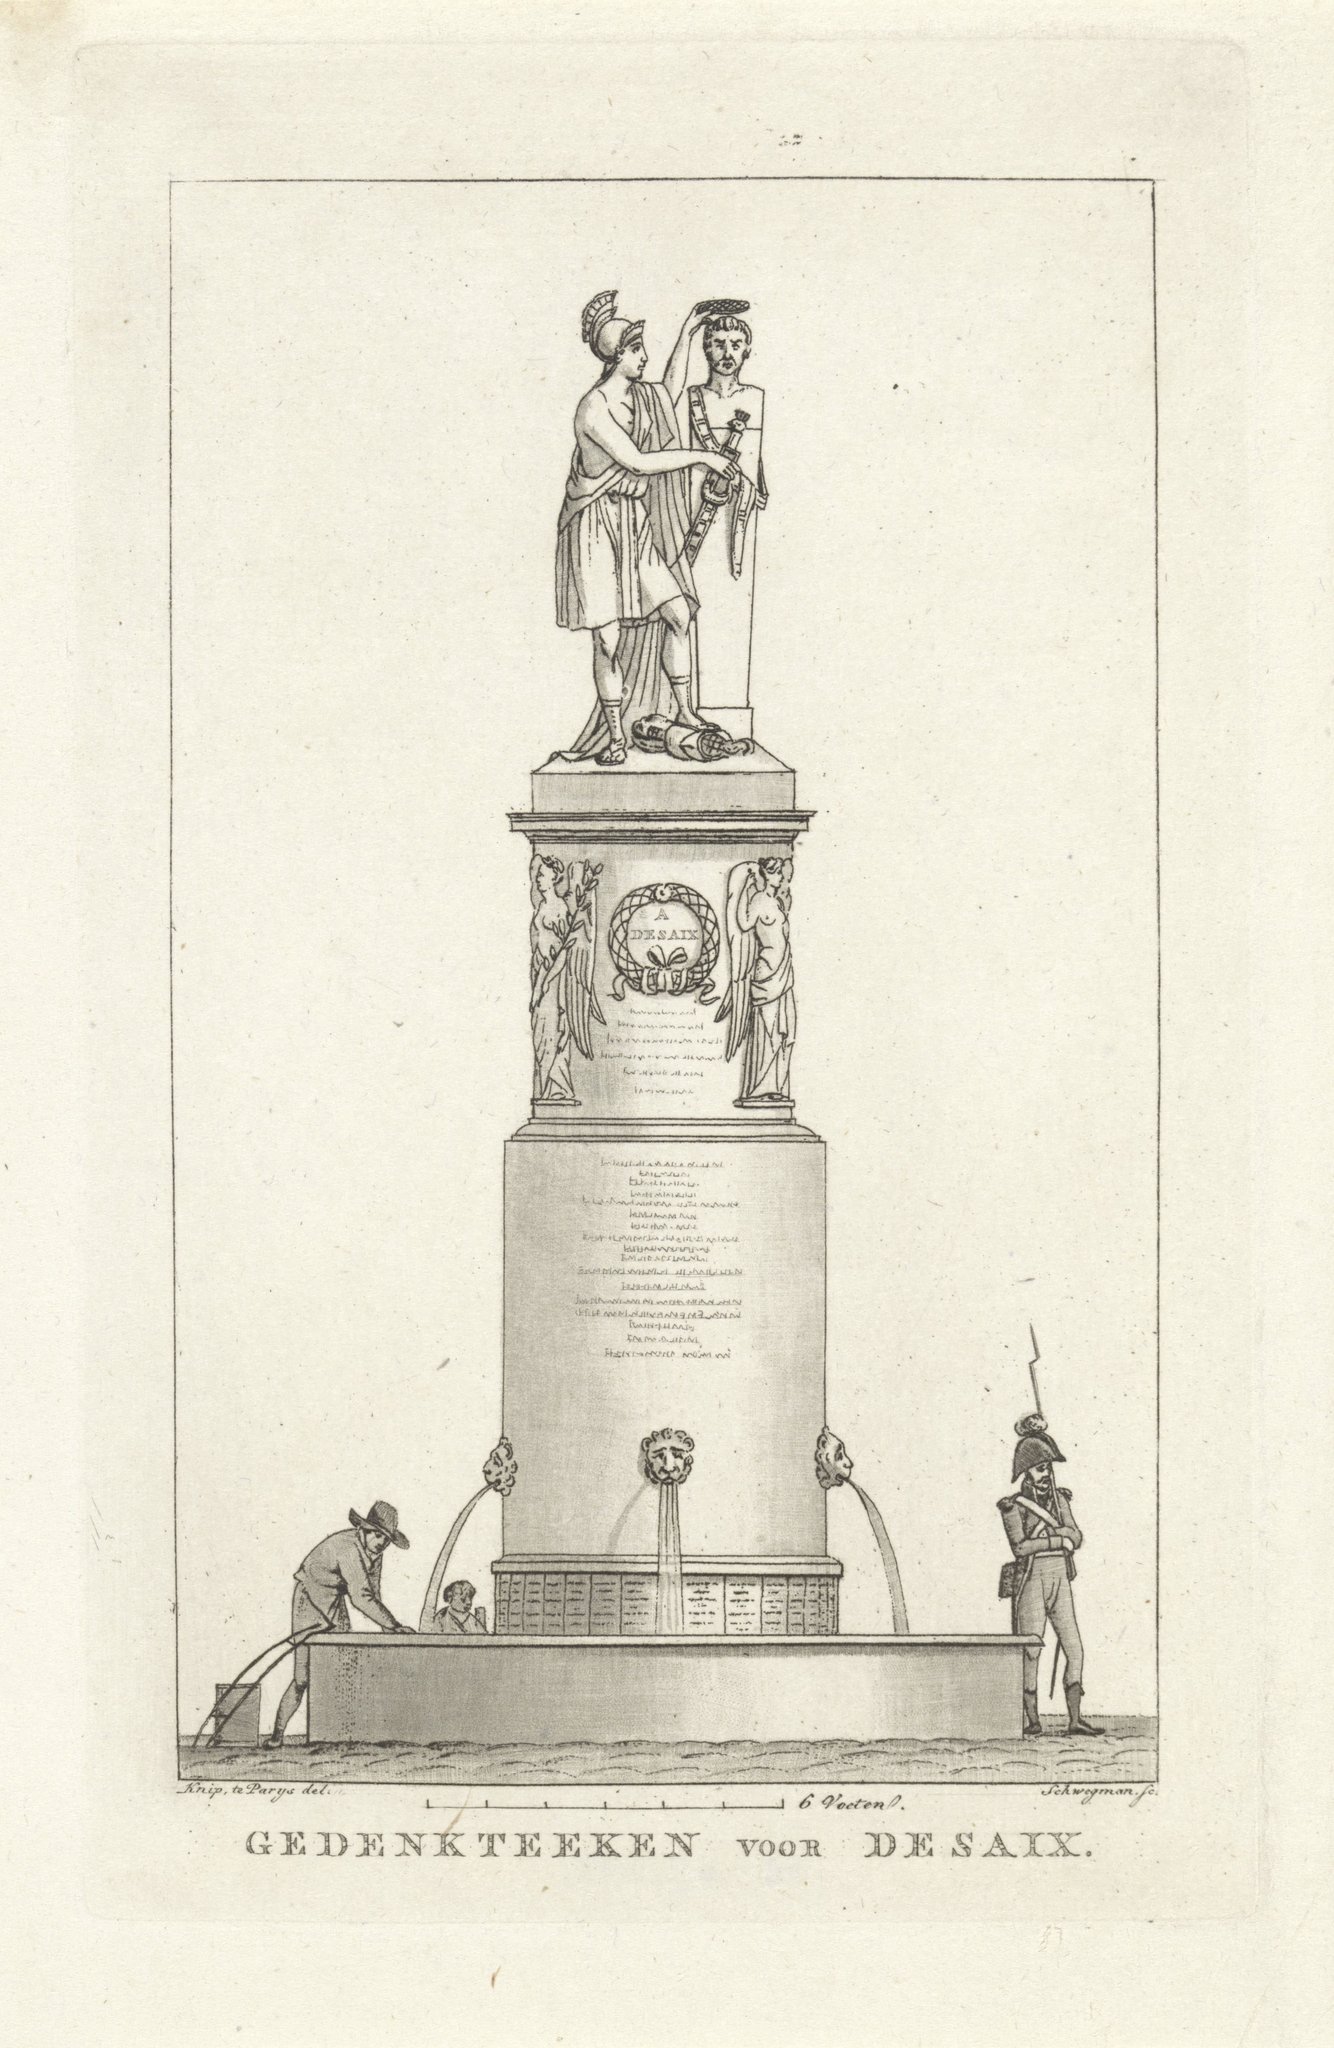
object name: print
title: Gedenkteken voor Louis Charles Antoine Desaix te Parijs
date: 1800-1816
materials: paper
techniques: etching, roulette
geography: paris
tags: monument, statue, paris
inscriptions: collector's mark: Lugt 2228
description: Een monument voor generaal Louis Charles Antoine Desaix te Parijs. Standbeeld van een Romeinse soldaat, die de buste van Desaix lauwert. Onderaan mensen bij de fontein.